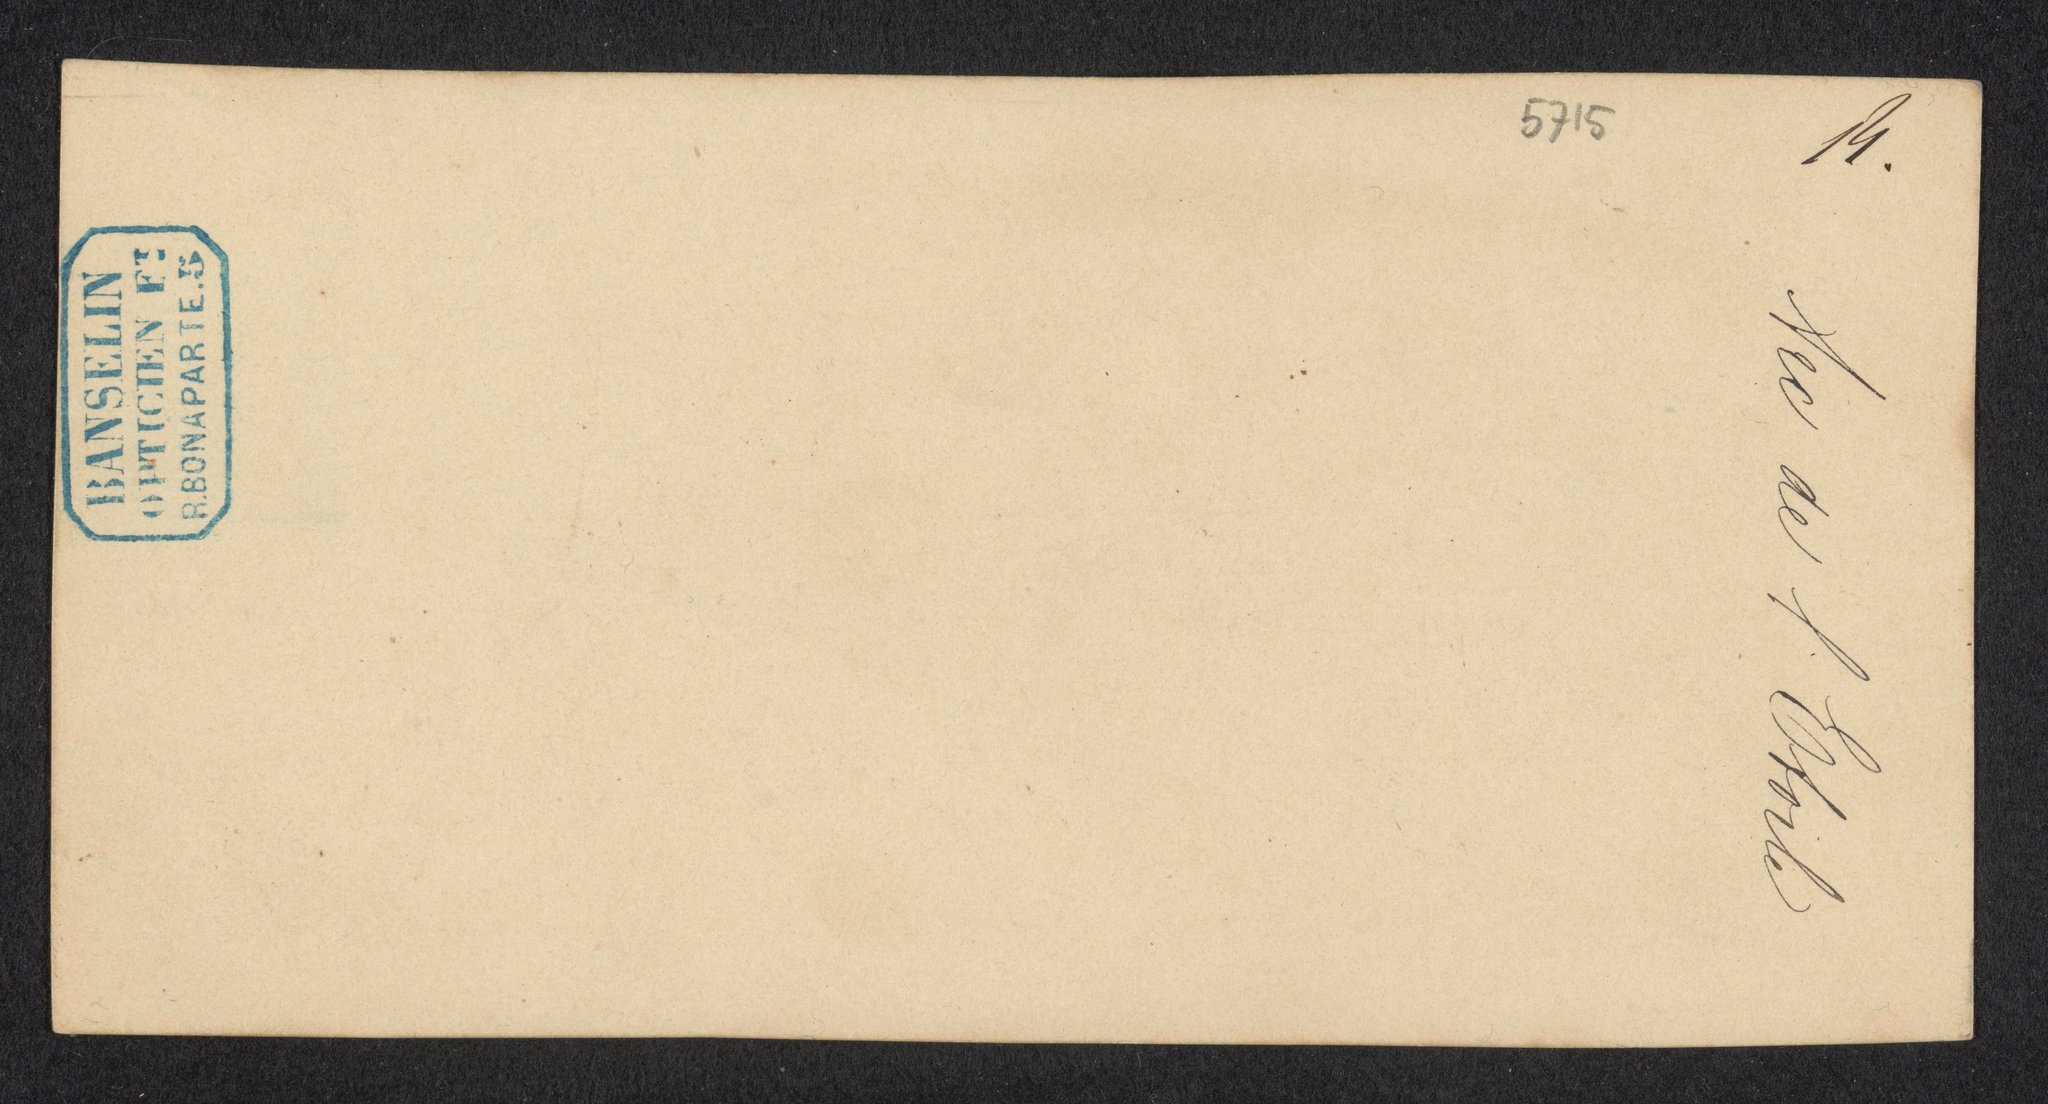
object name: stereograph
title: Gezicht op de Arc de Triomphe in Parijs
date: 1855-1860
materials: cardboard, photographic support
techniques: albumen print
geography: paris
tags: triumphal arch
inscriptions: inscription: ‘Arc de l'Etoile’, number: ‘14.’